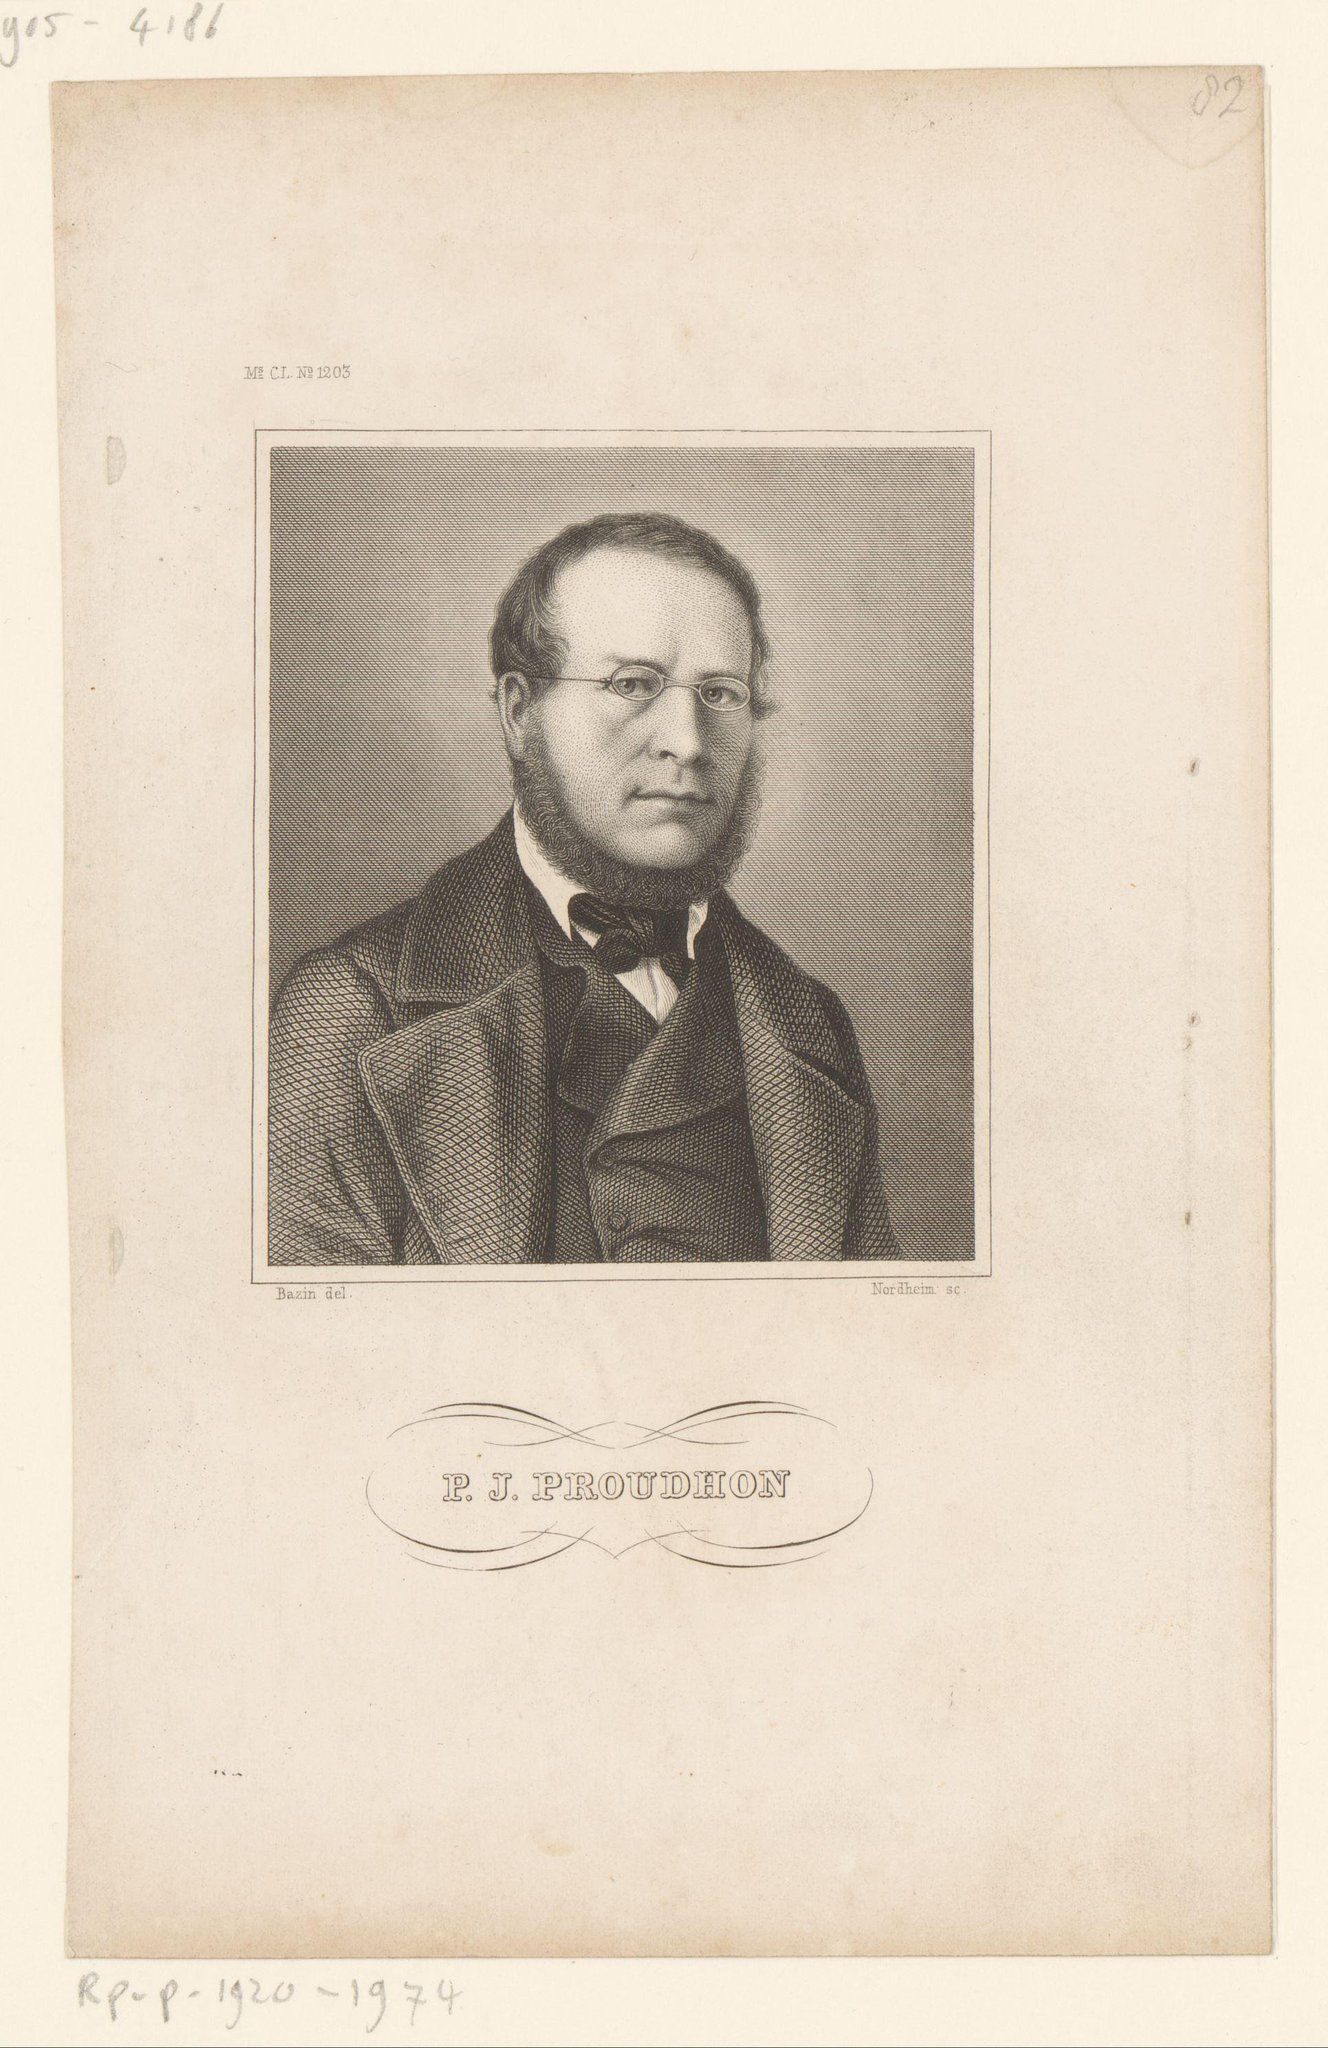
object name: book illustration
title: Portret van Pierre-Joseph Proudhon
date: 1840-1855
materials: paper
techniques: engraving, etching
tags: paris, historical persons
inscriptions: collector's mark: Lugt 2228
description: Prent afkomstig uit: Conversations-Lexikon für die gebildeten Stände, voor het eerst uitgegeven tussen 1840-1855.